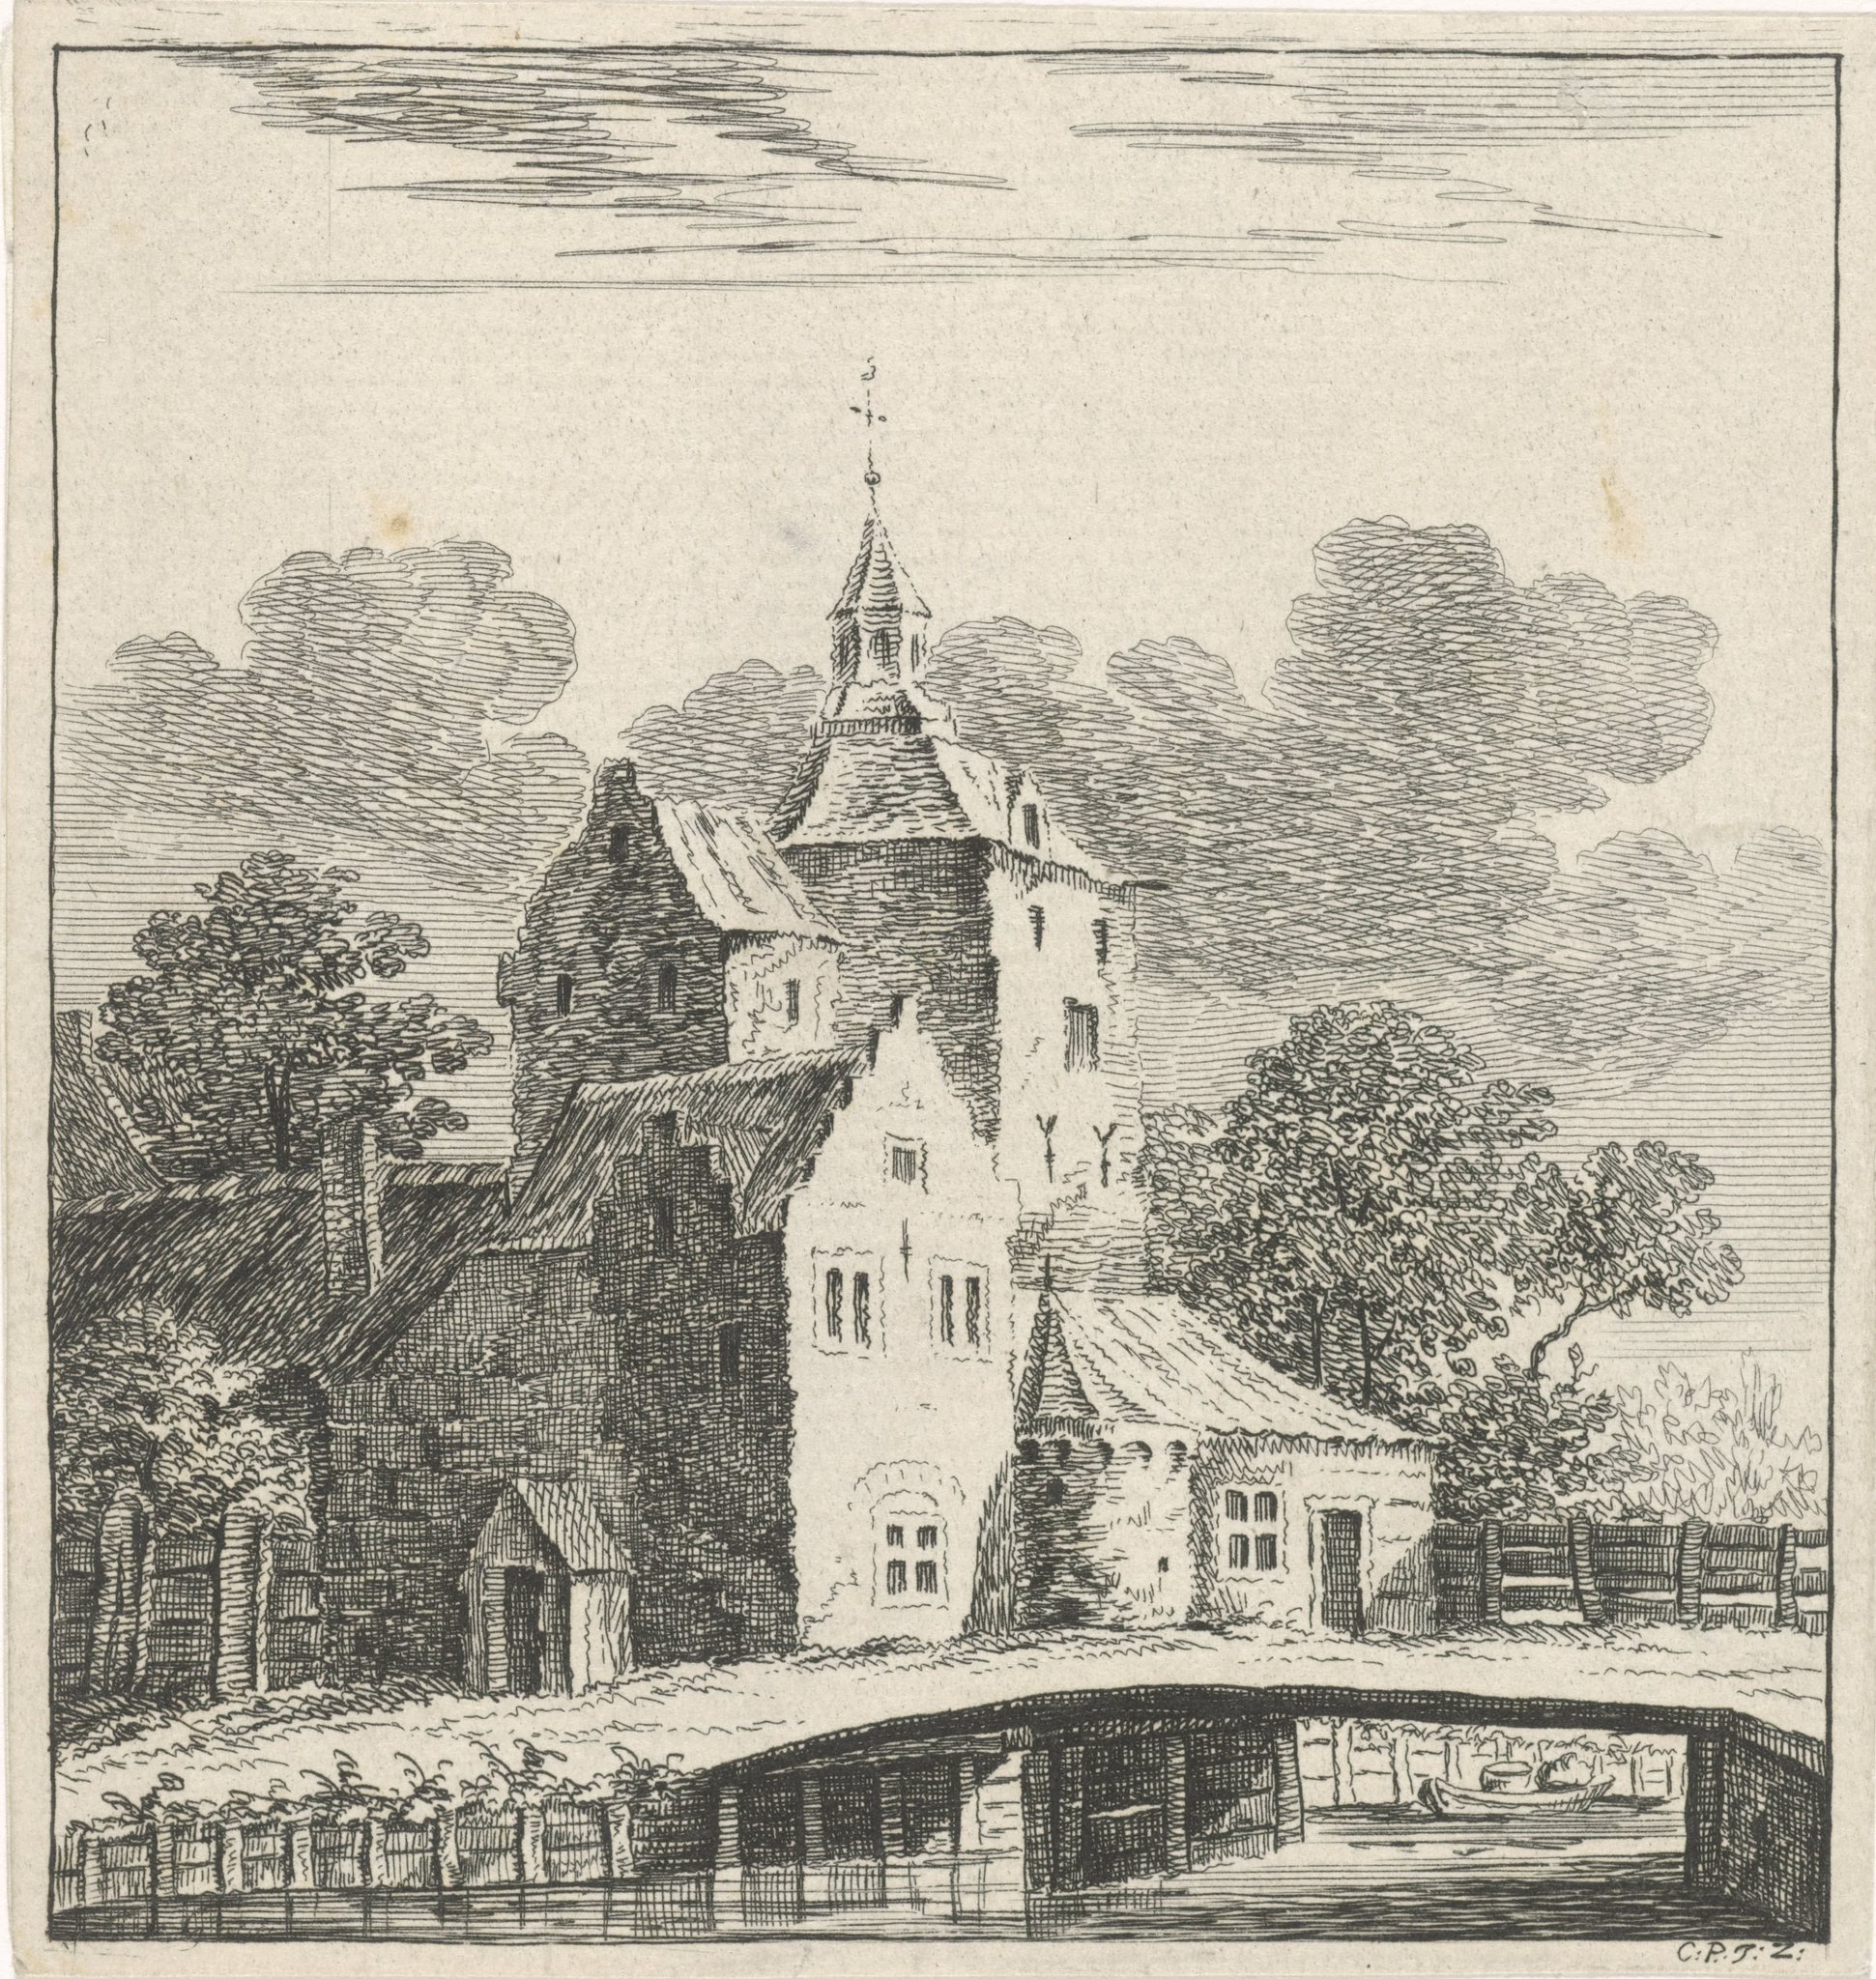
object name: print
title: Landschapjes, Rúwientjes enz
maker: caspar jacobsz. philips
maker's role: draughtsman, print maker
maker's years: 1732-1789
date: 1766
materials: paper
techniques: etching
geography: amsterdam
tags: rural housing, e.g. country-house, villa, cottage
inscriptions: collector's mark: Lugt 240